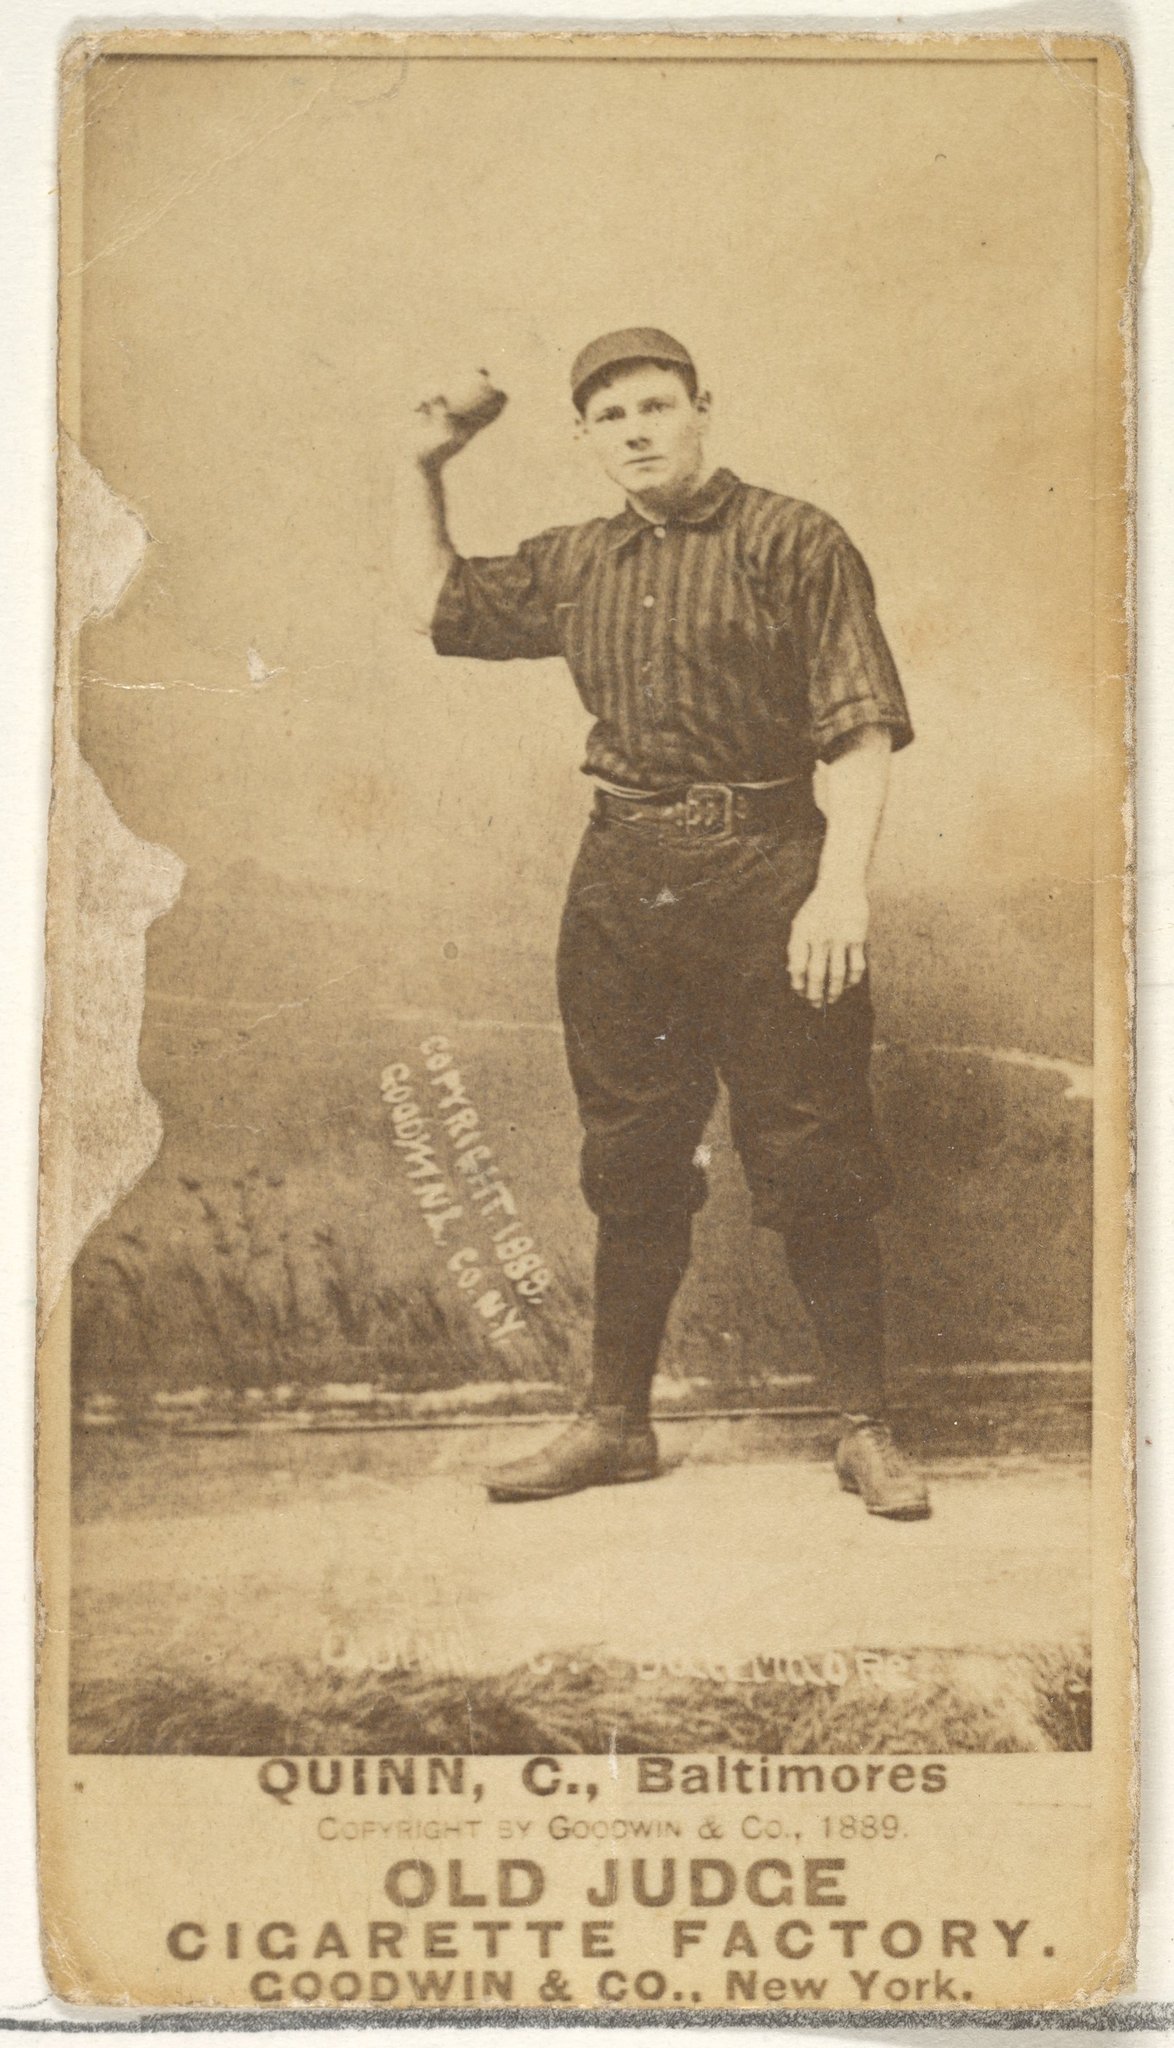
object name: baseball card, photograph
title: Quinn, Catcher, Baltimore Orioles, from the Old Judge series (N172) for Old Judge Cigarettes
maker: goodwin & company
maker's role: publisher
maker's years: 1850-1950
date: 1889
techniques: albumen silver print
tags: men,portraits,baseball,athletes